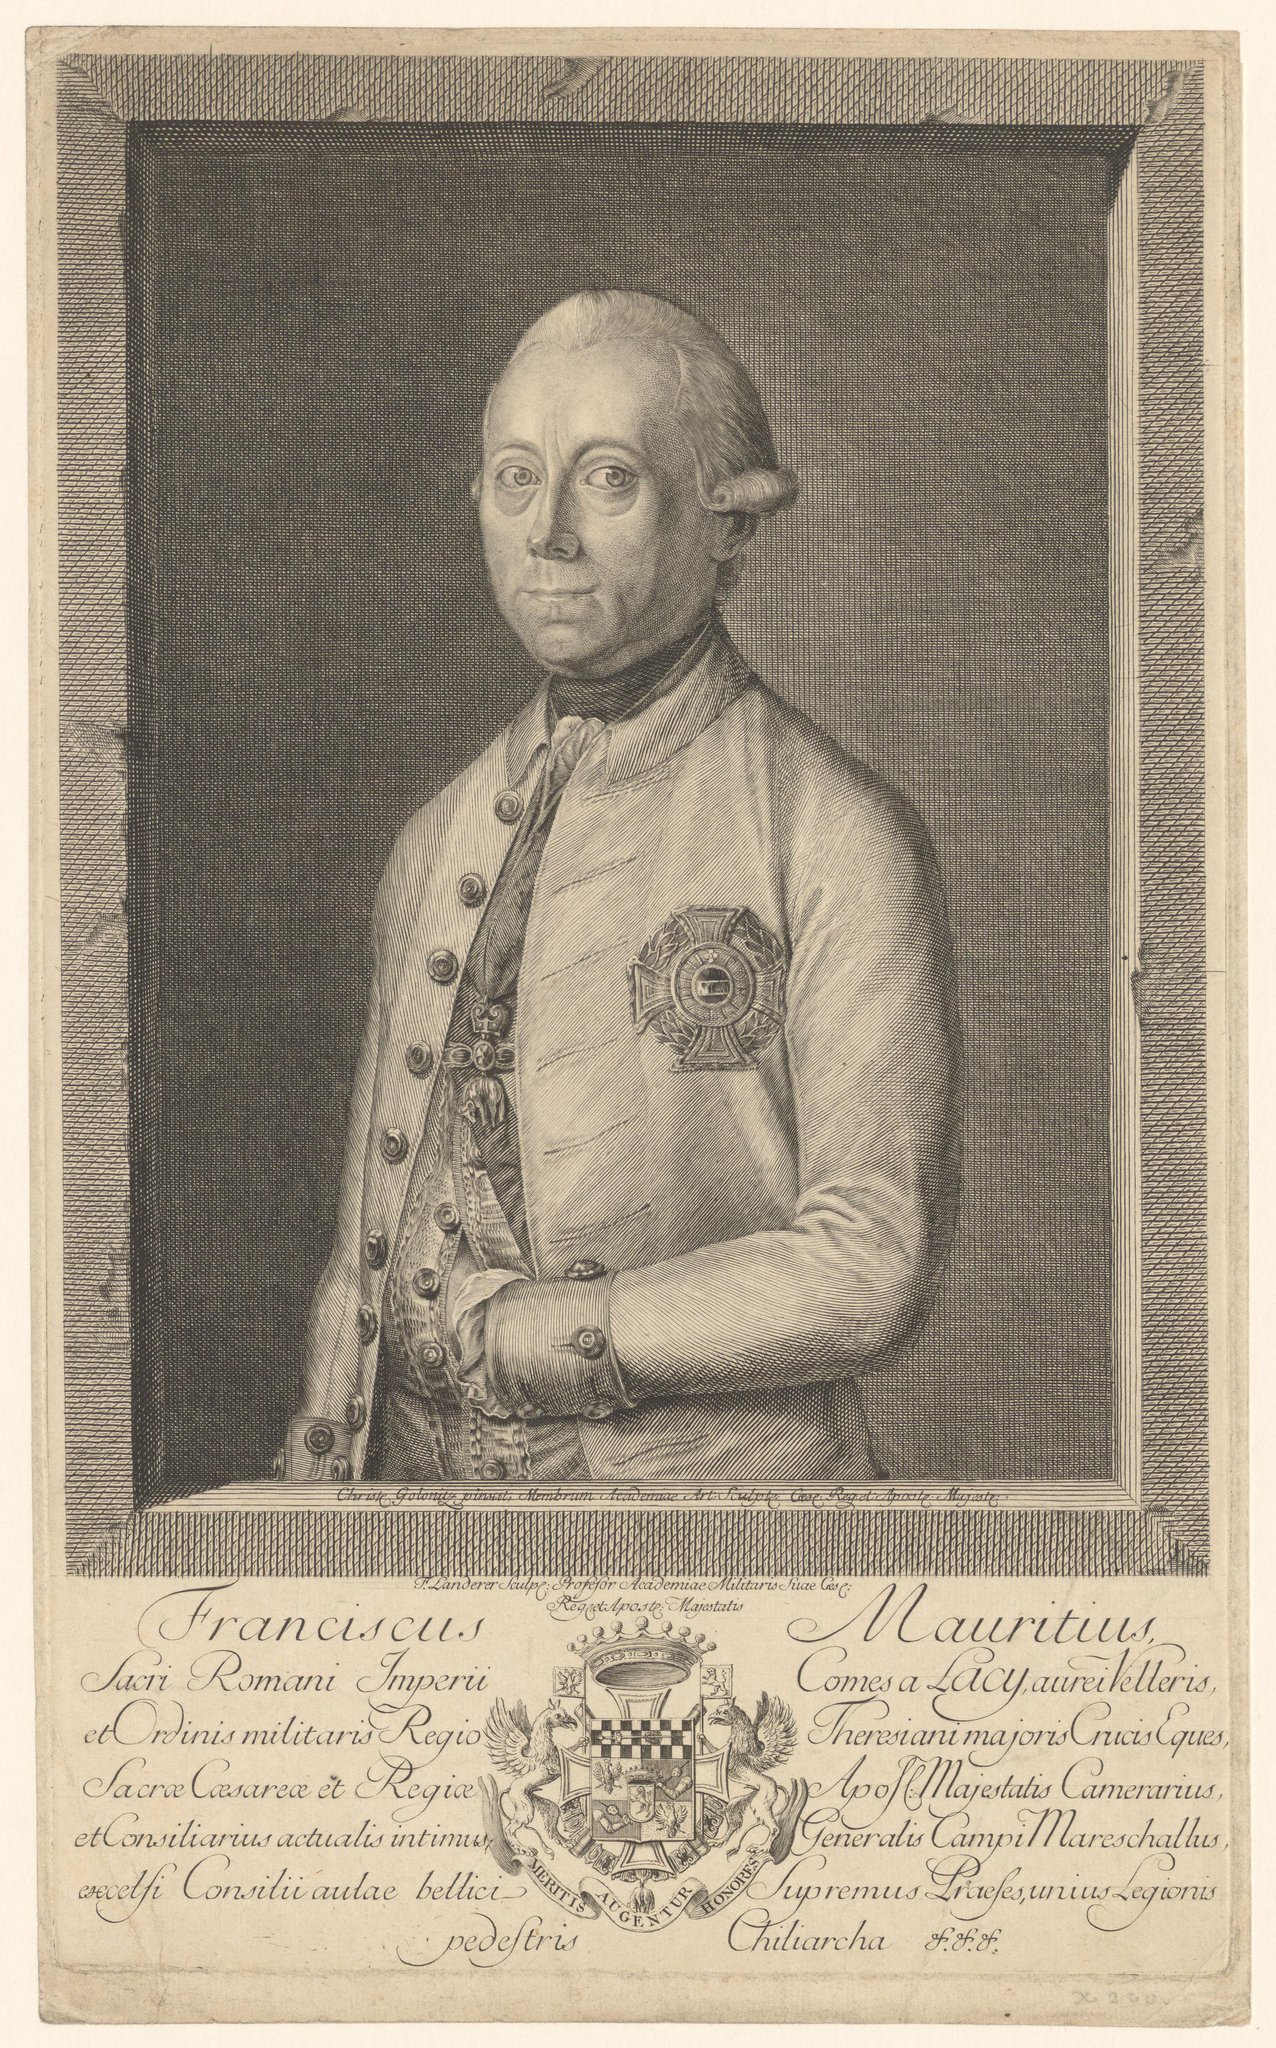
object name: print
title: Portret van Joseph Franz Moritz von Lacy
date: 1740-1795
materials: paper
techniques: engraving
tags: vienna, commander-in-chief, general, marshal, historical persons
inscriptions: collector's mark: Lugt 2228